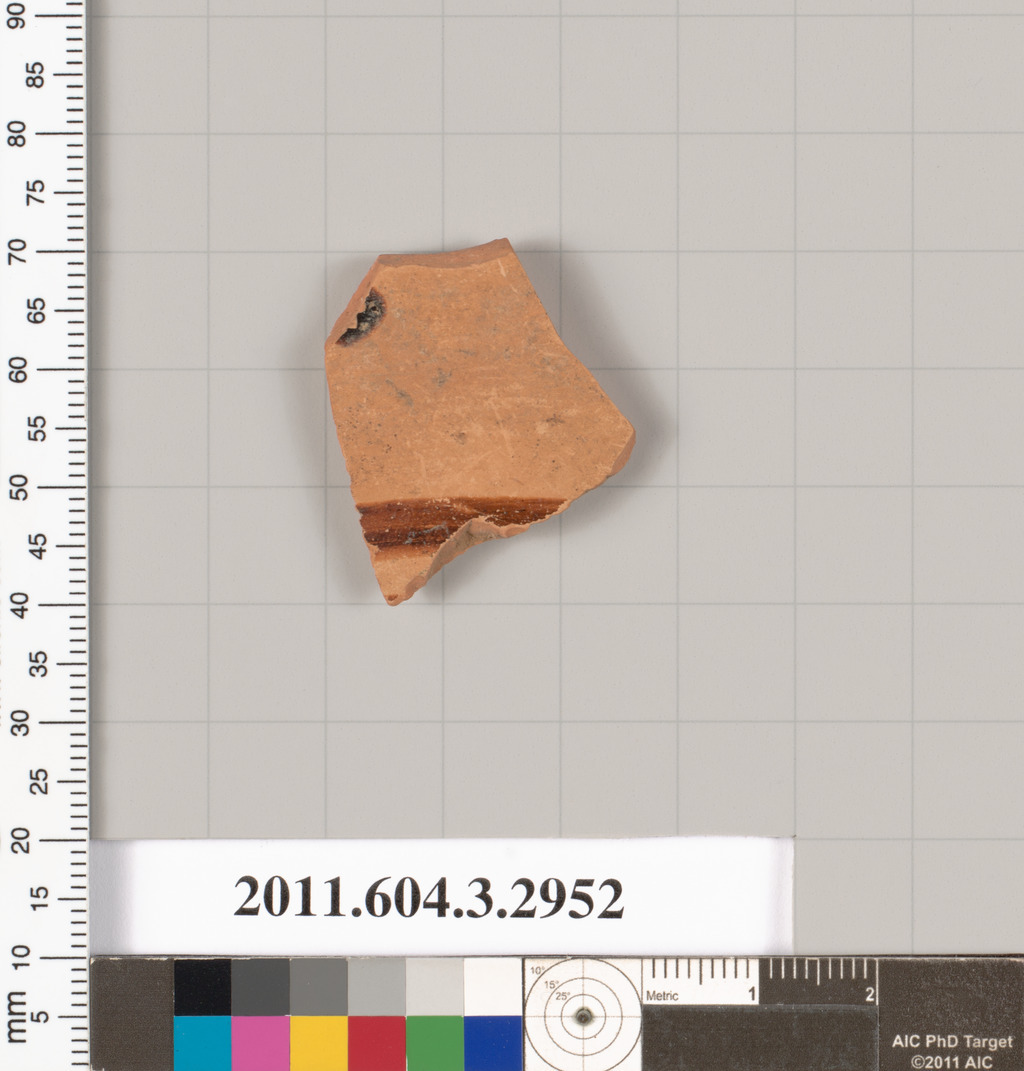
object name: undetermined closed shape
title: Terracotta fragment of a closed shape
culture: greek, attic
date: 600-551 BCE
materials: terracotta